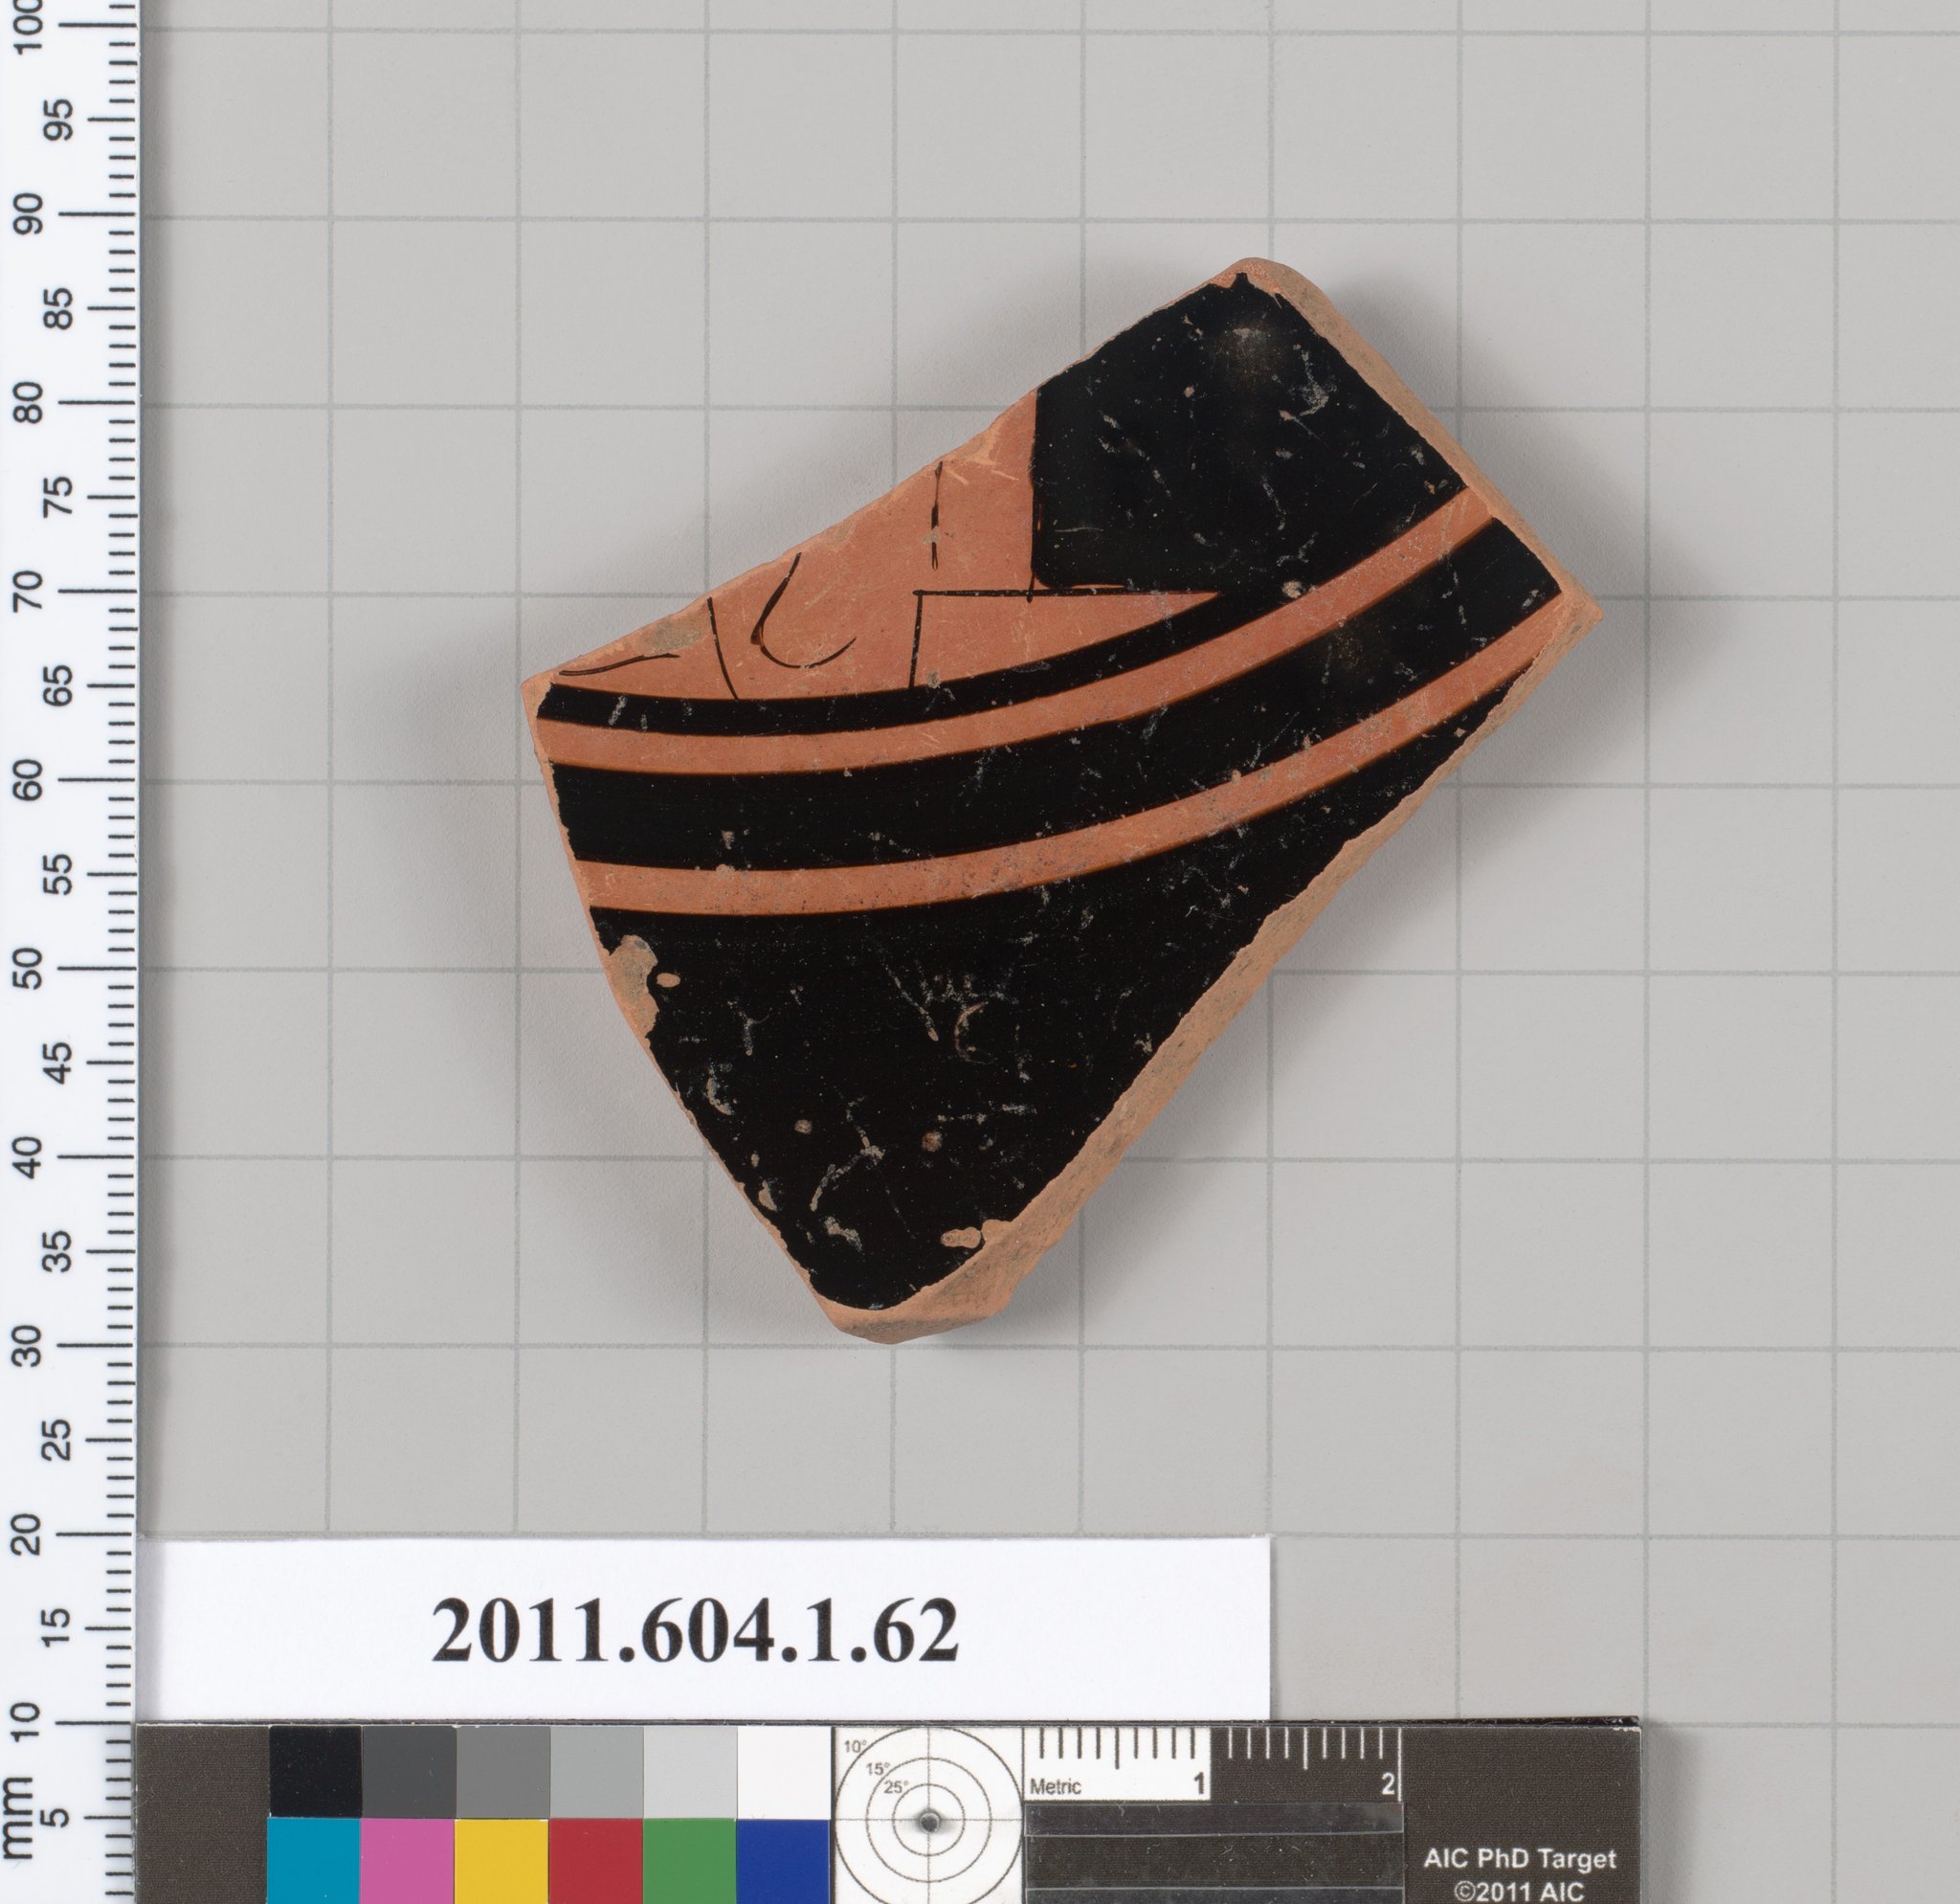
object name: kylix fragment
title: Terracotta fragment of a kylix (drinking cup)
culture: greek, attic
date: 467-435 BCE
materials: terracotta